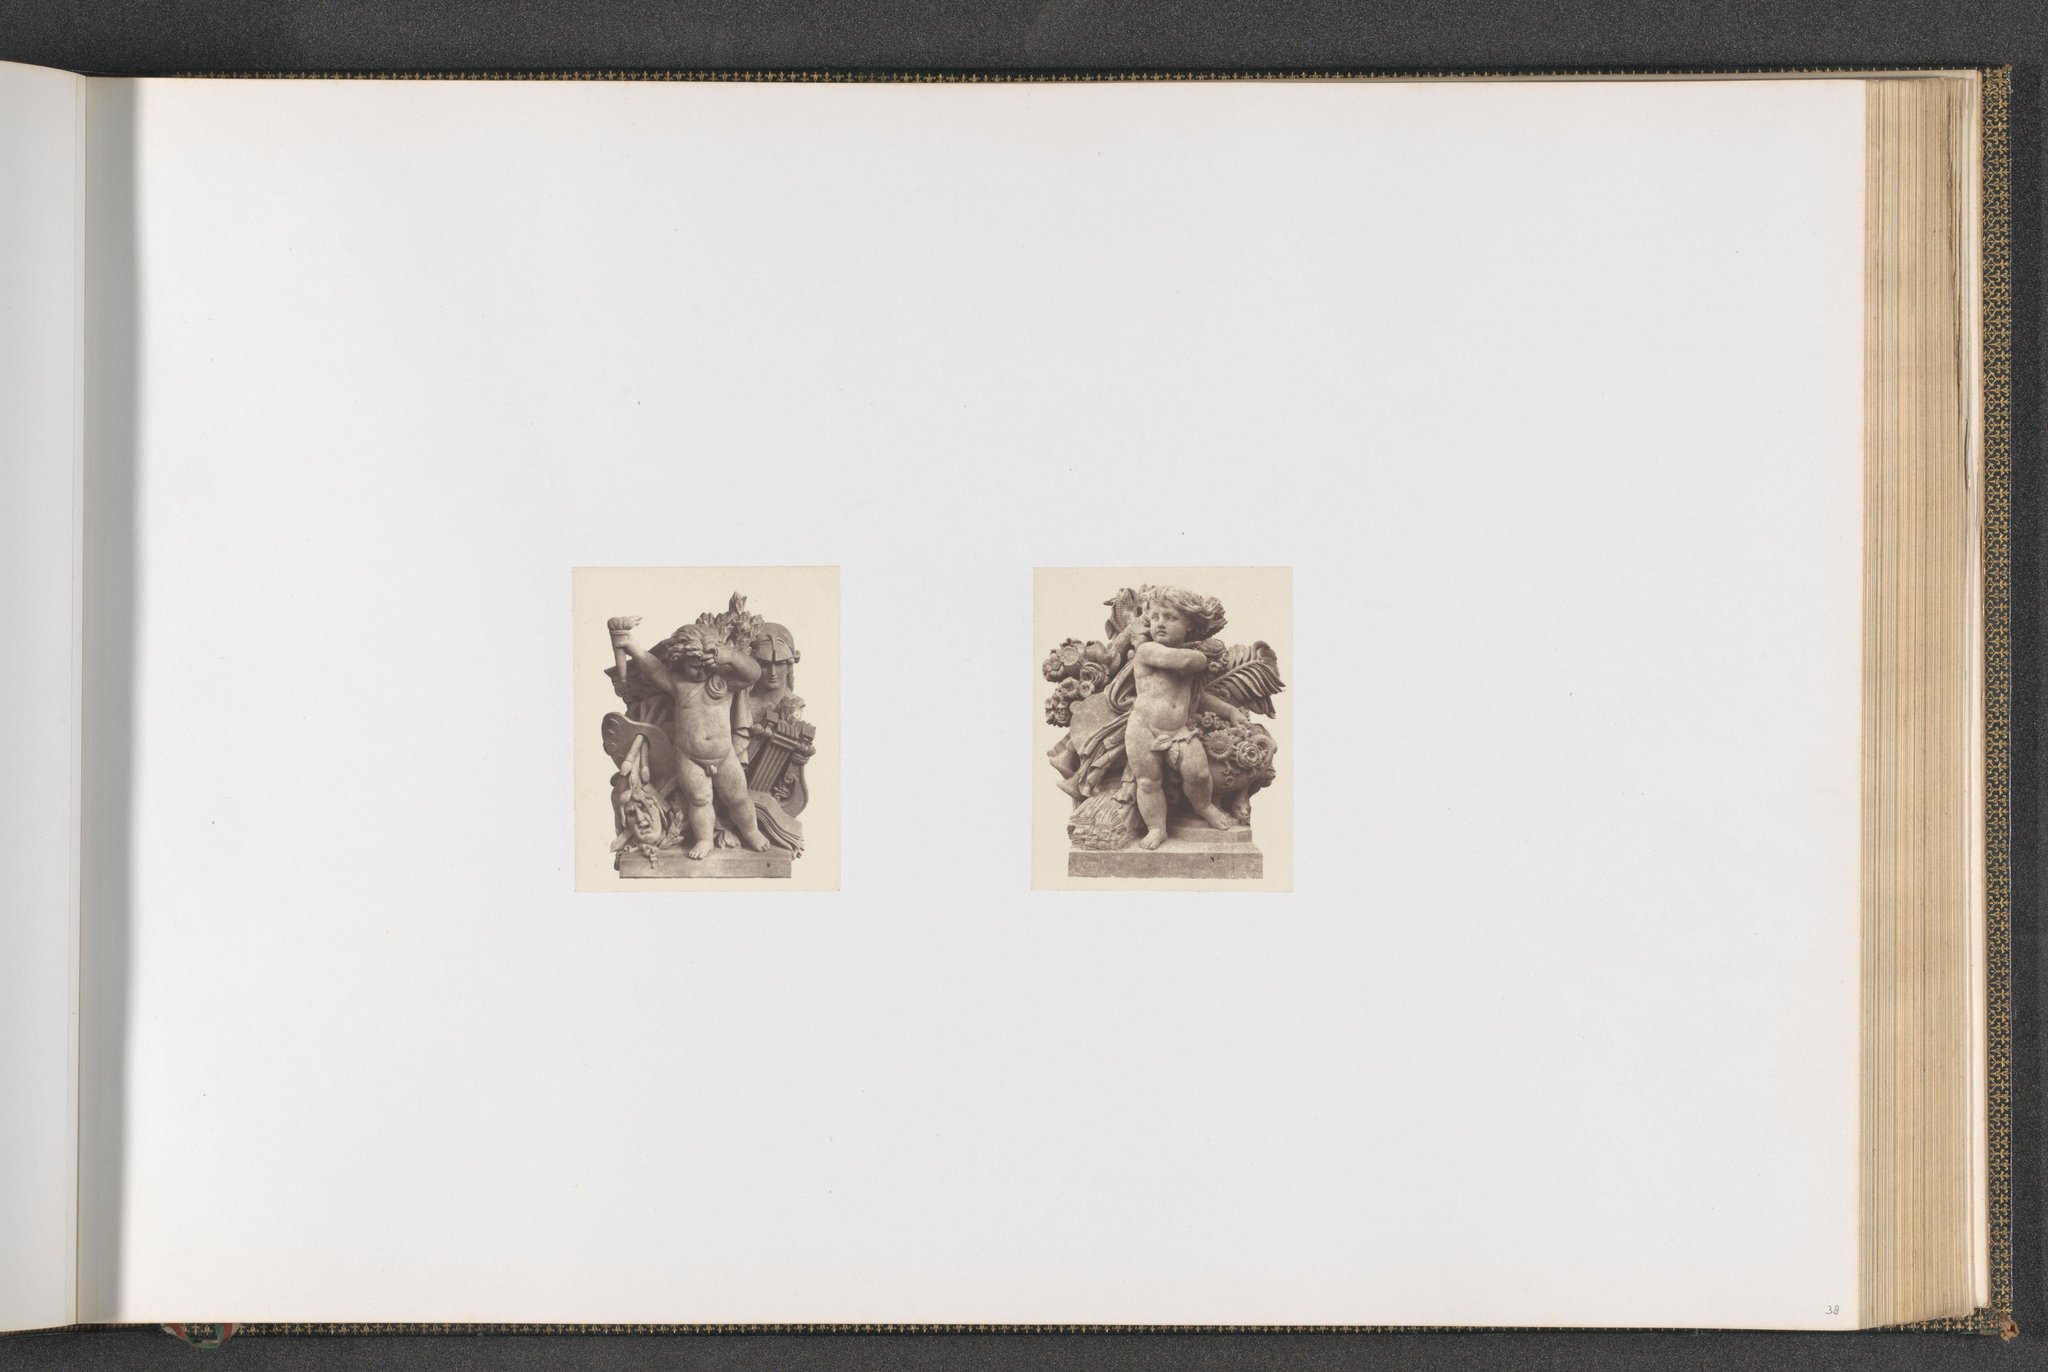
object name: album leaf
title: Gipsmodellen voor beeldhouwwerken op het Palais du Louvre: links "Les Beaux-arts" door Nicolas Guillemin en rechts "L'Eté" door Wladyslaw Tomasz Kazimierz Oleszczynski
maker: édouard denis baldus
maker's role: fotograaf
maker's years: 1813-1889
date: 1855-1857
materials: paper, photographic support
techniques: salted paper print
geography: paris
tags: piece of sculpture, reproduction of a piece of sculpture, permanent exhibition, museum, paris, tuileries palace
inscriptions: number: ‘M en N’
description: Onderdeel van Réunion des Tuileries au Louvre 1852-1857, album 2.